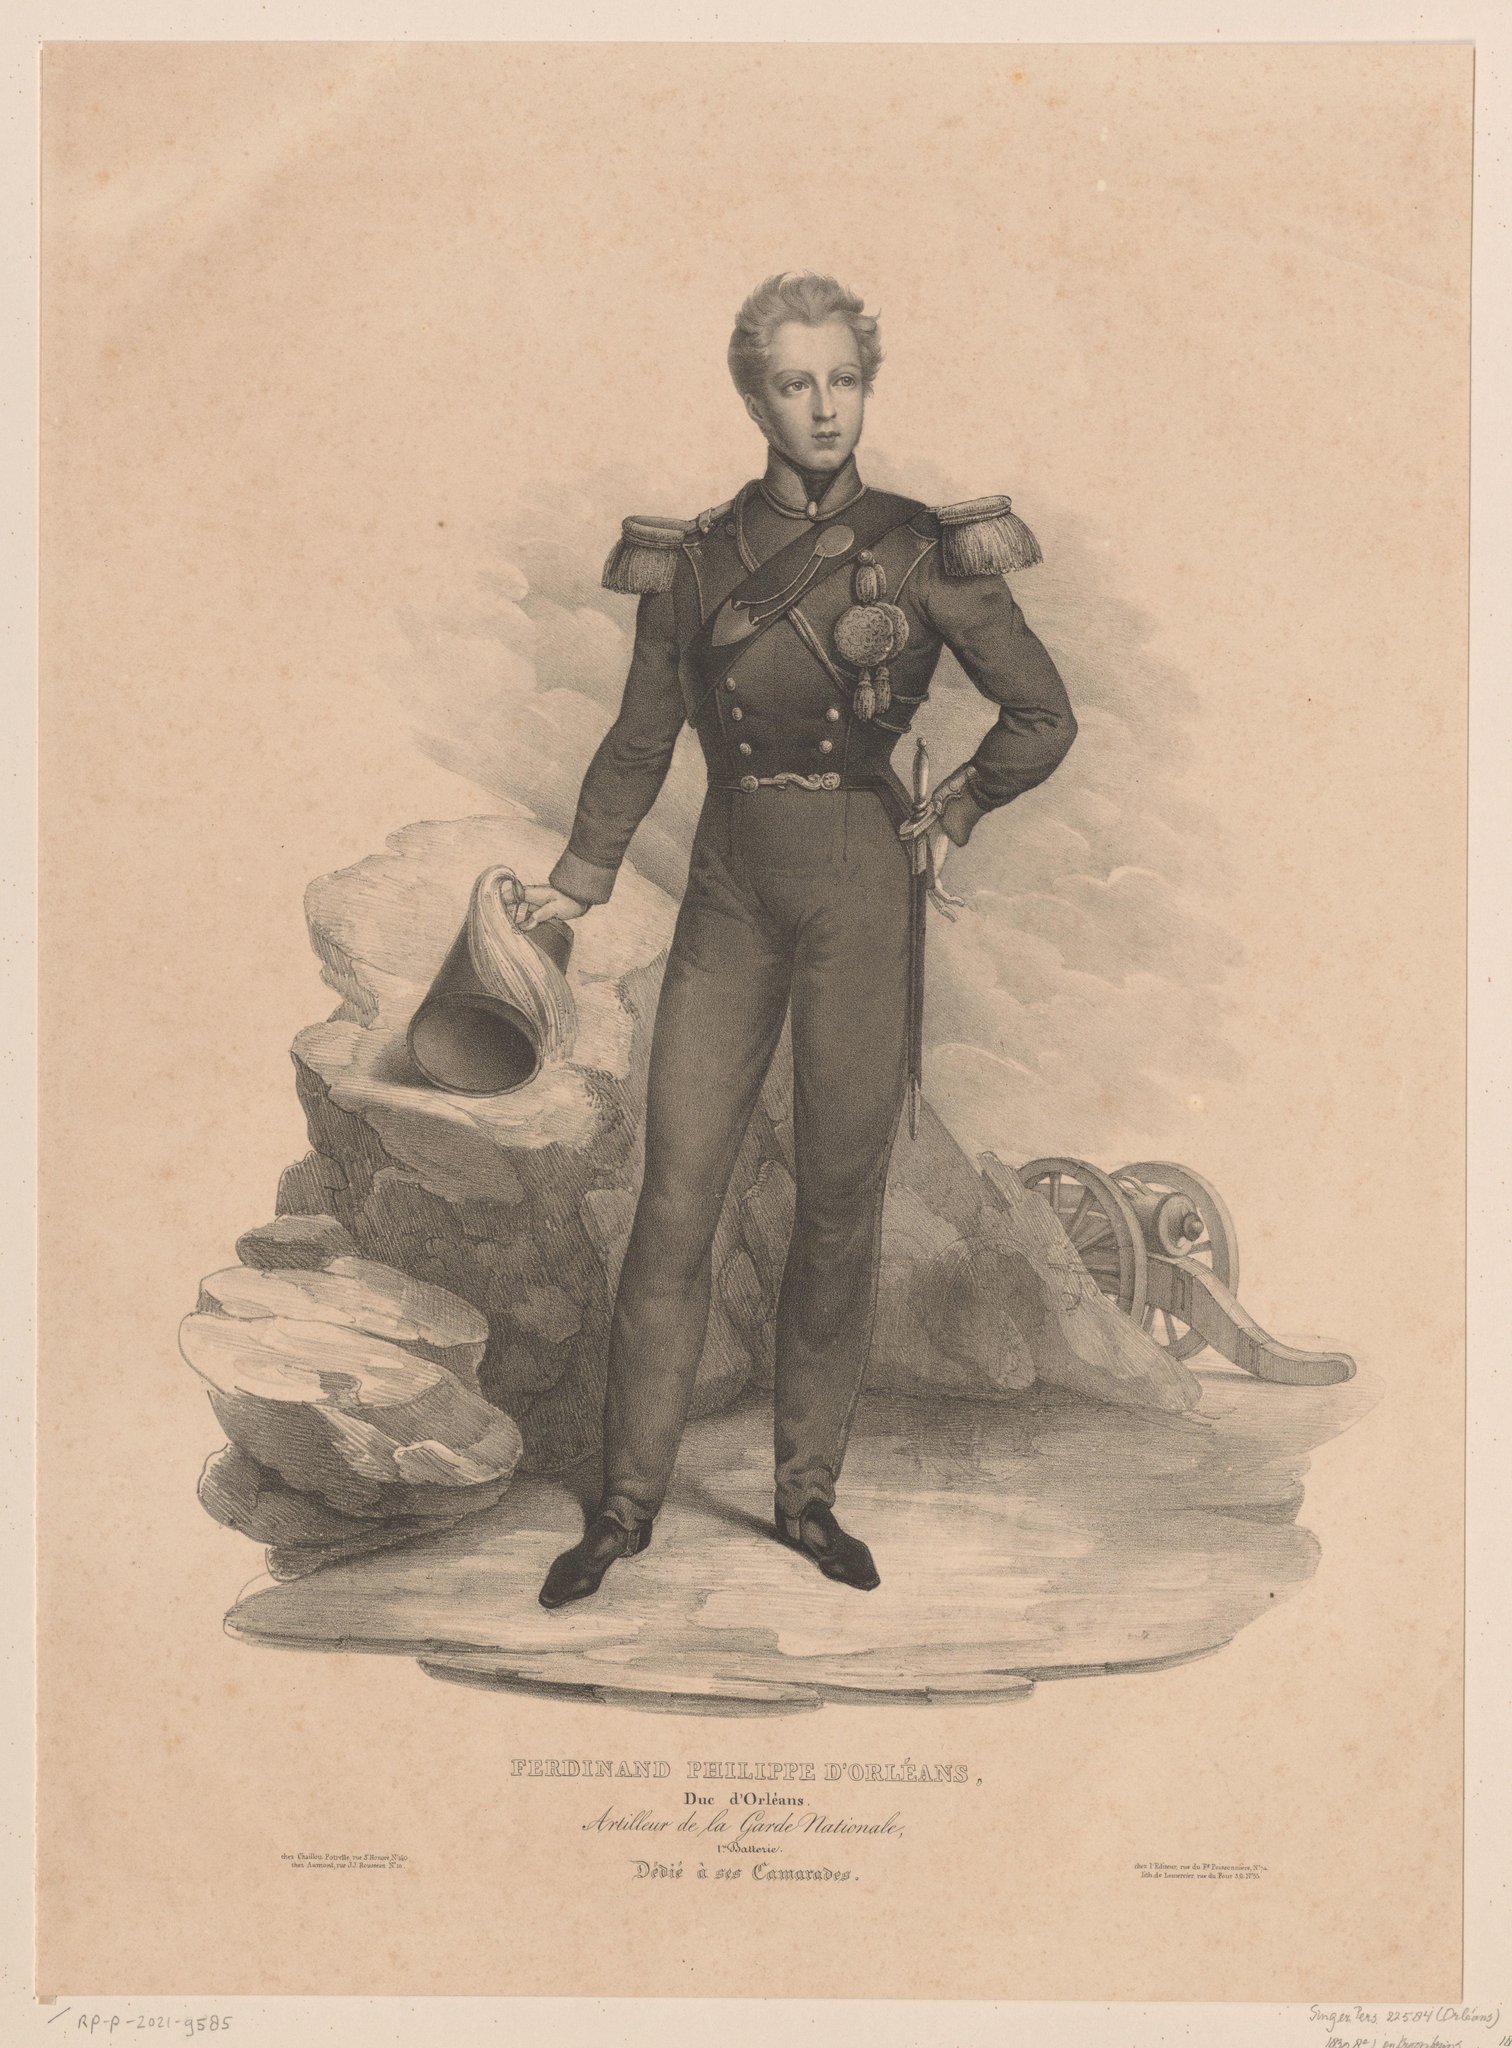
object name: print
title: Portret van Ferdinand Filips van Orléans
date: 1829-1833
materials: paper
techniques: lithograph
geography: paris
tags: historical persons, (military) uniforms, crown prince